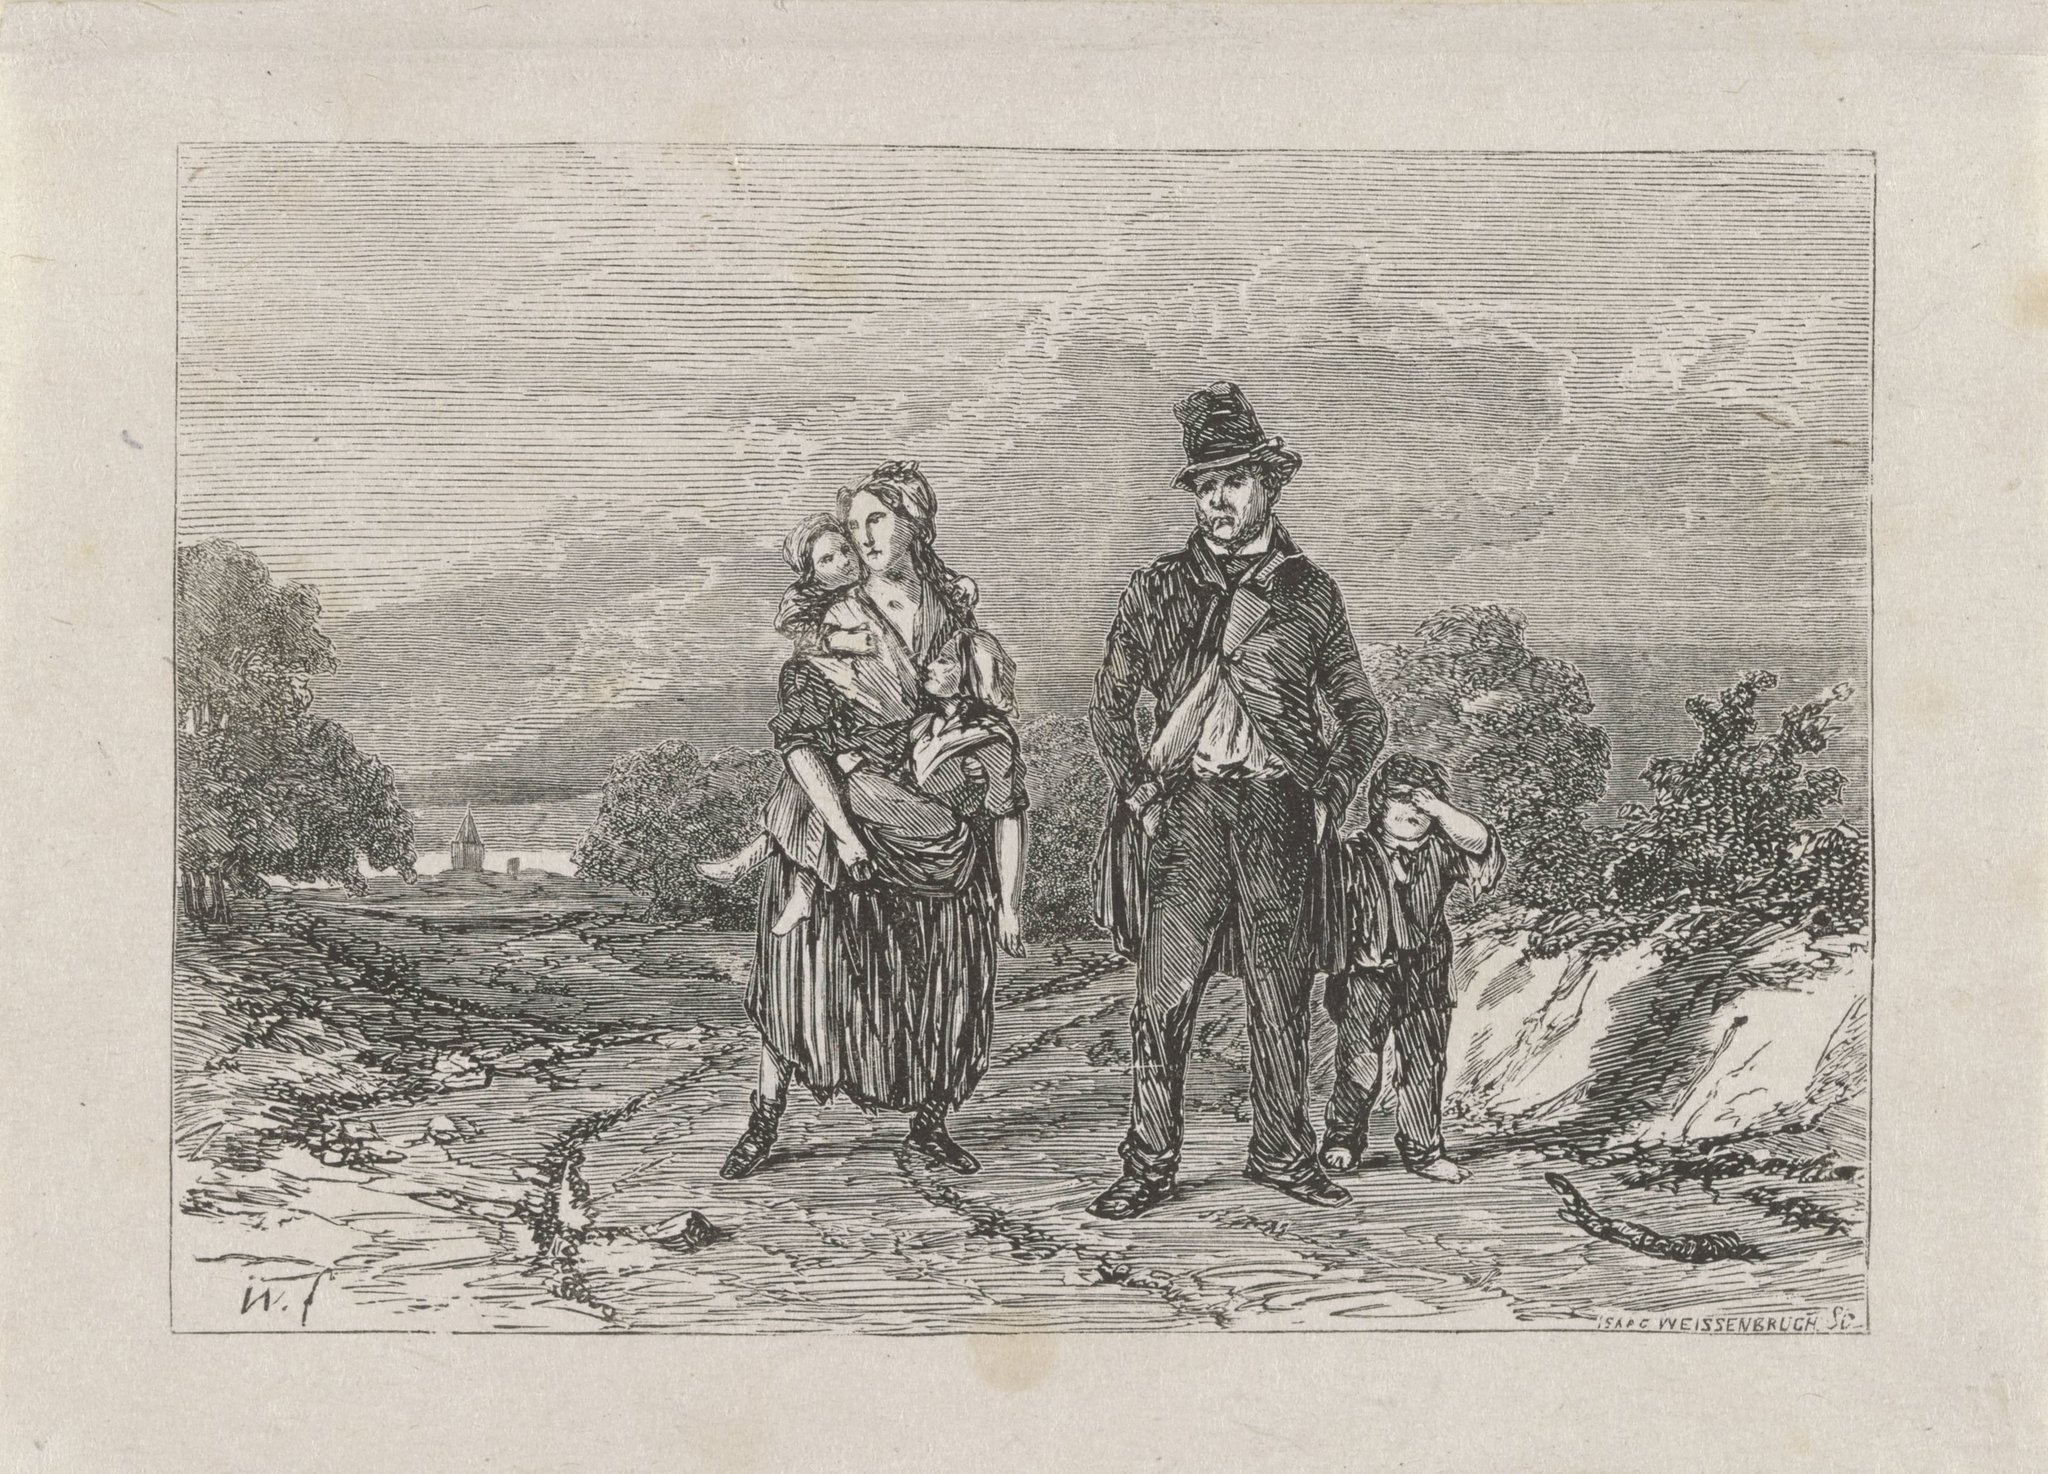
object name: print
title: Arm gezin lopend op een landweg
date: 1836-1912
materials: paper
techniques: engraving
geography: netherlands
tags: road, path, family life, walking, the poor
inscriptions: collector's mark: Lugt 2228